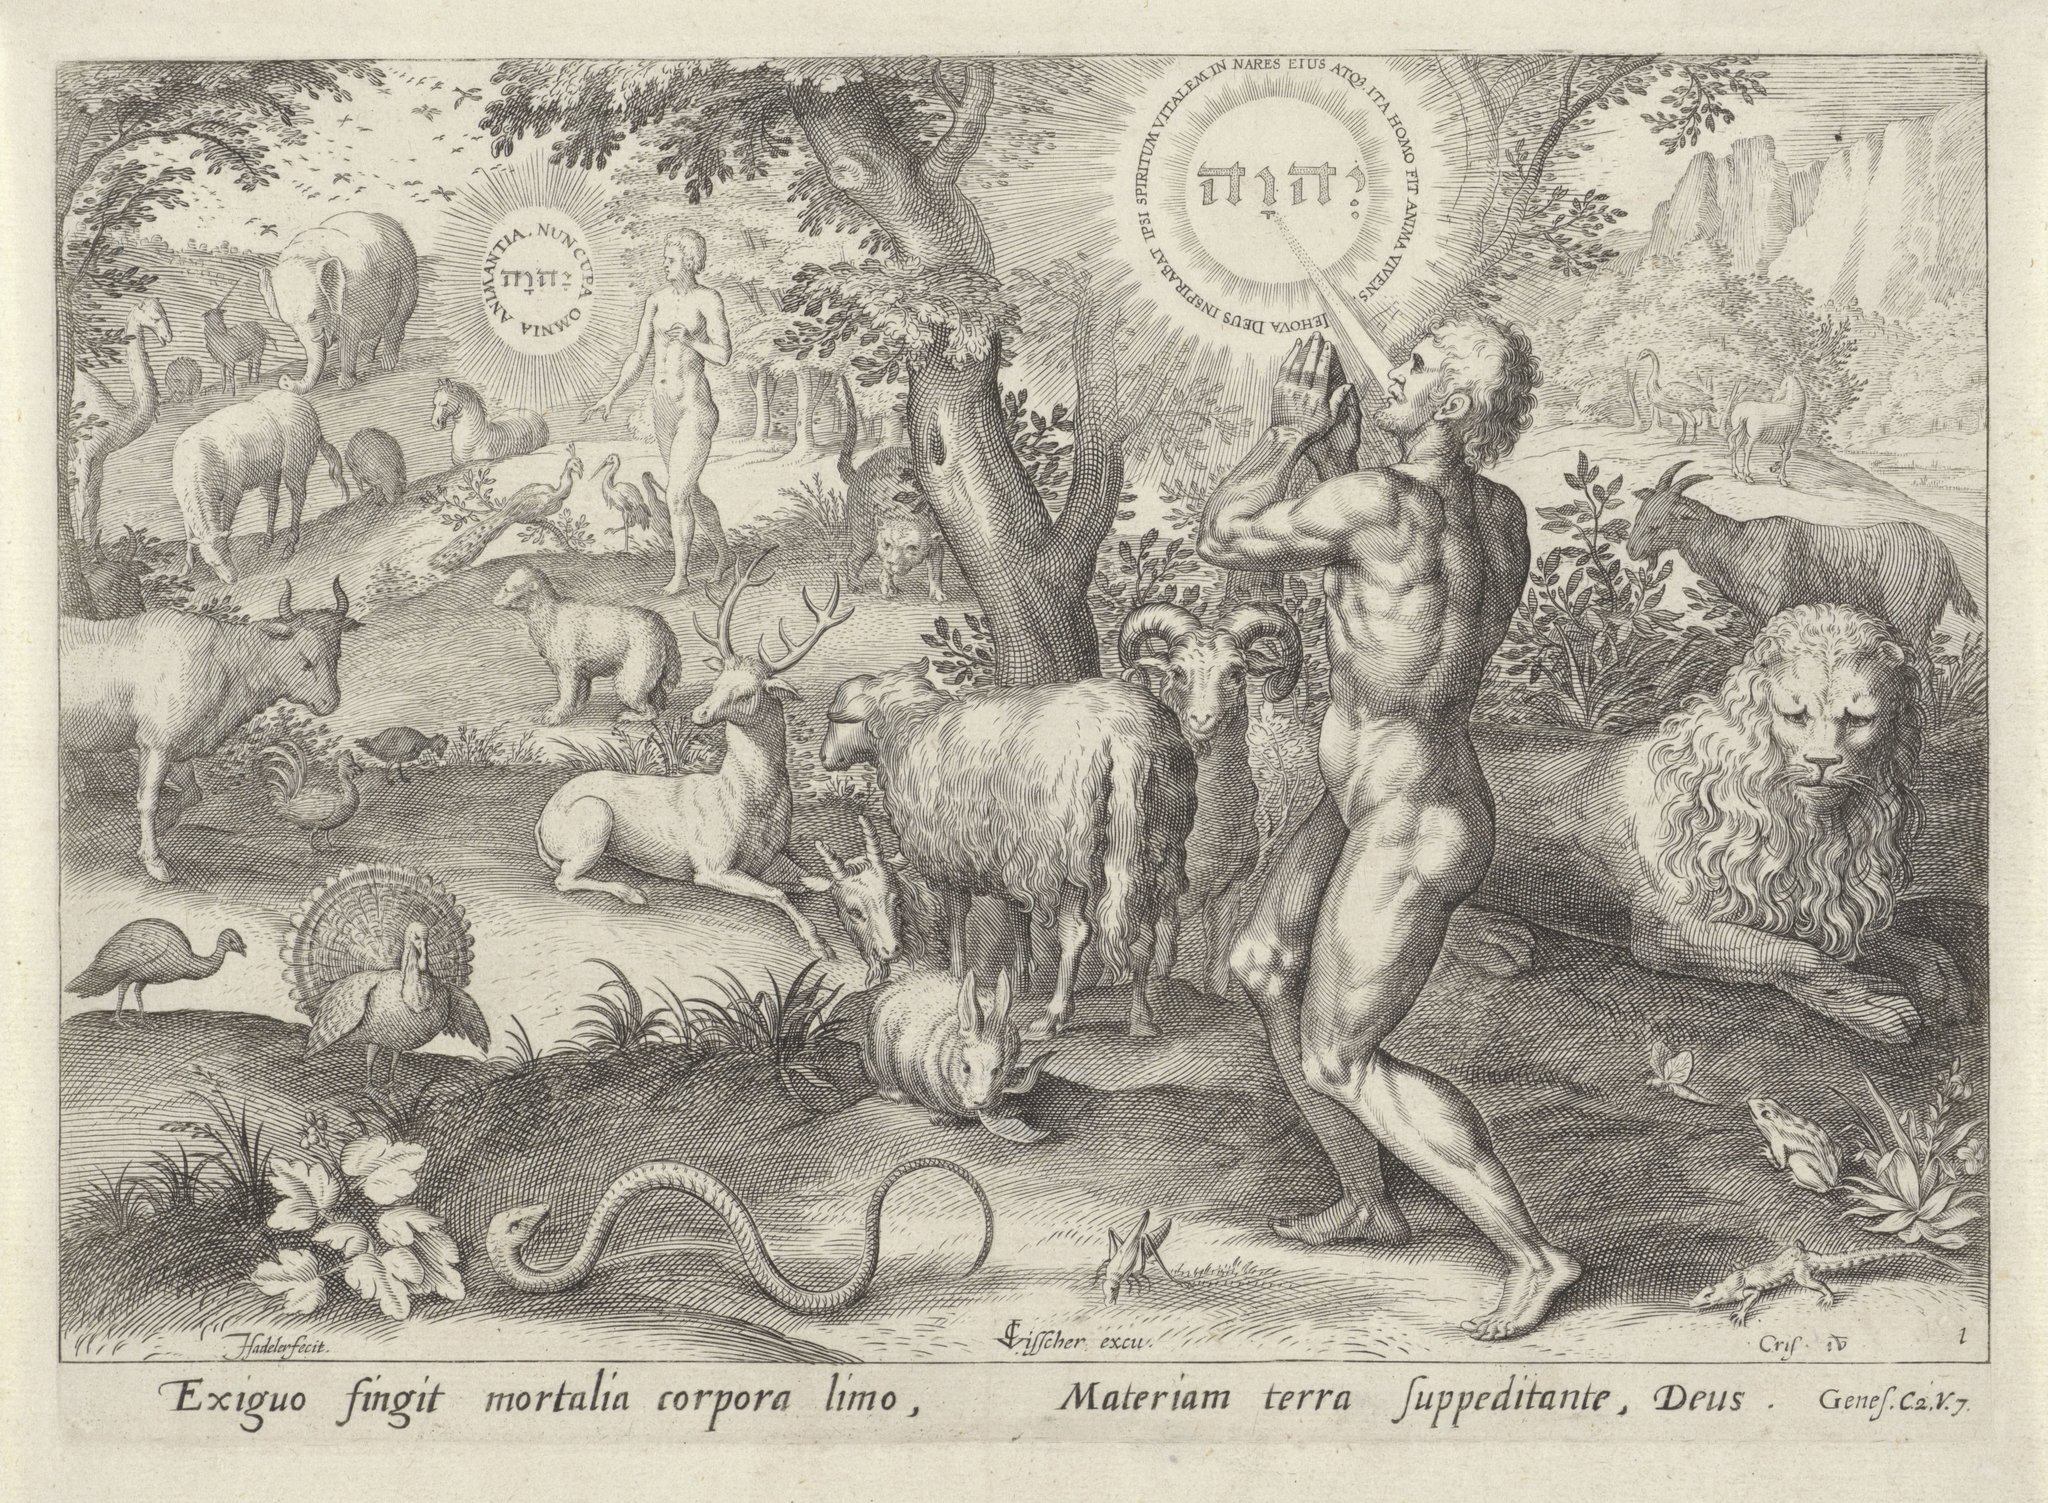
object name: print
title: Zondeval van de mens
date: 1575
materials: paper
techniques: engraving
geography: antwerp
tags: god speaks to adam, the man (adam) comes to life: usually god reaches out his hand or breathes life into his nostrils (+ god the father in the form of light), animals, tetragram (in roman or hebrew script) ~ symbol of god the father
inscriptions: collector's mark: Lugt 2228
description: De schepping van Adam. Een tetragram als symbool voor God blaast de naakte Adam leven in. Op de achtergrond leidt God (opnieuw als tetragram) Adam rond in het Aards Paradijs.